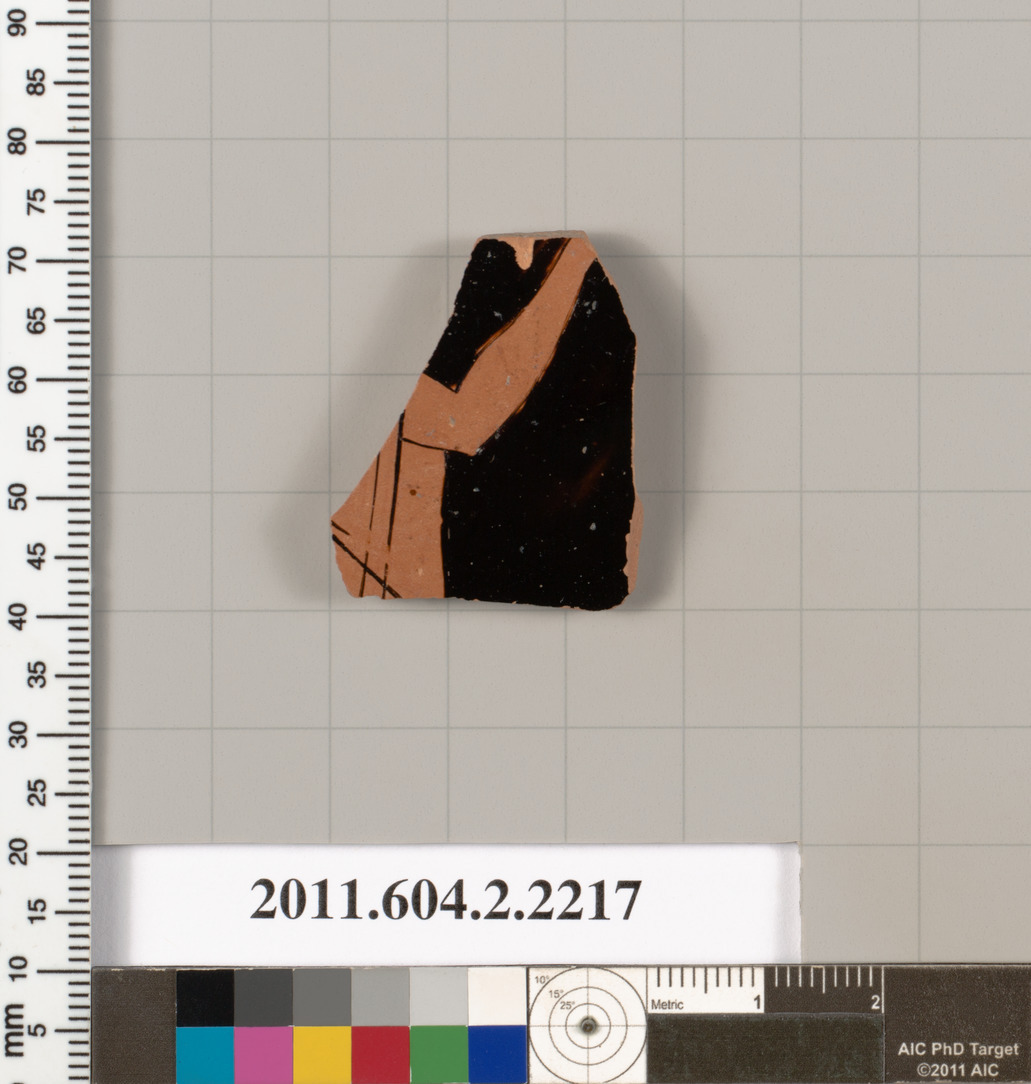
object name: pot fragment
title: Terracotta fragment of a pot; unglazed on the inside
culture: greek, attic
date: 475-451 BCE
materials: terracotta